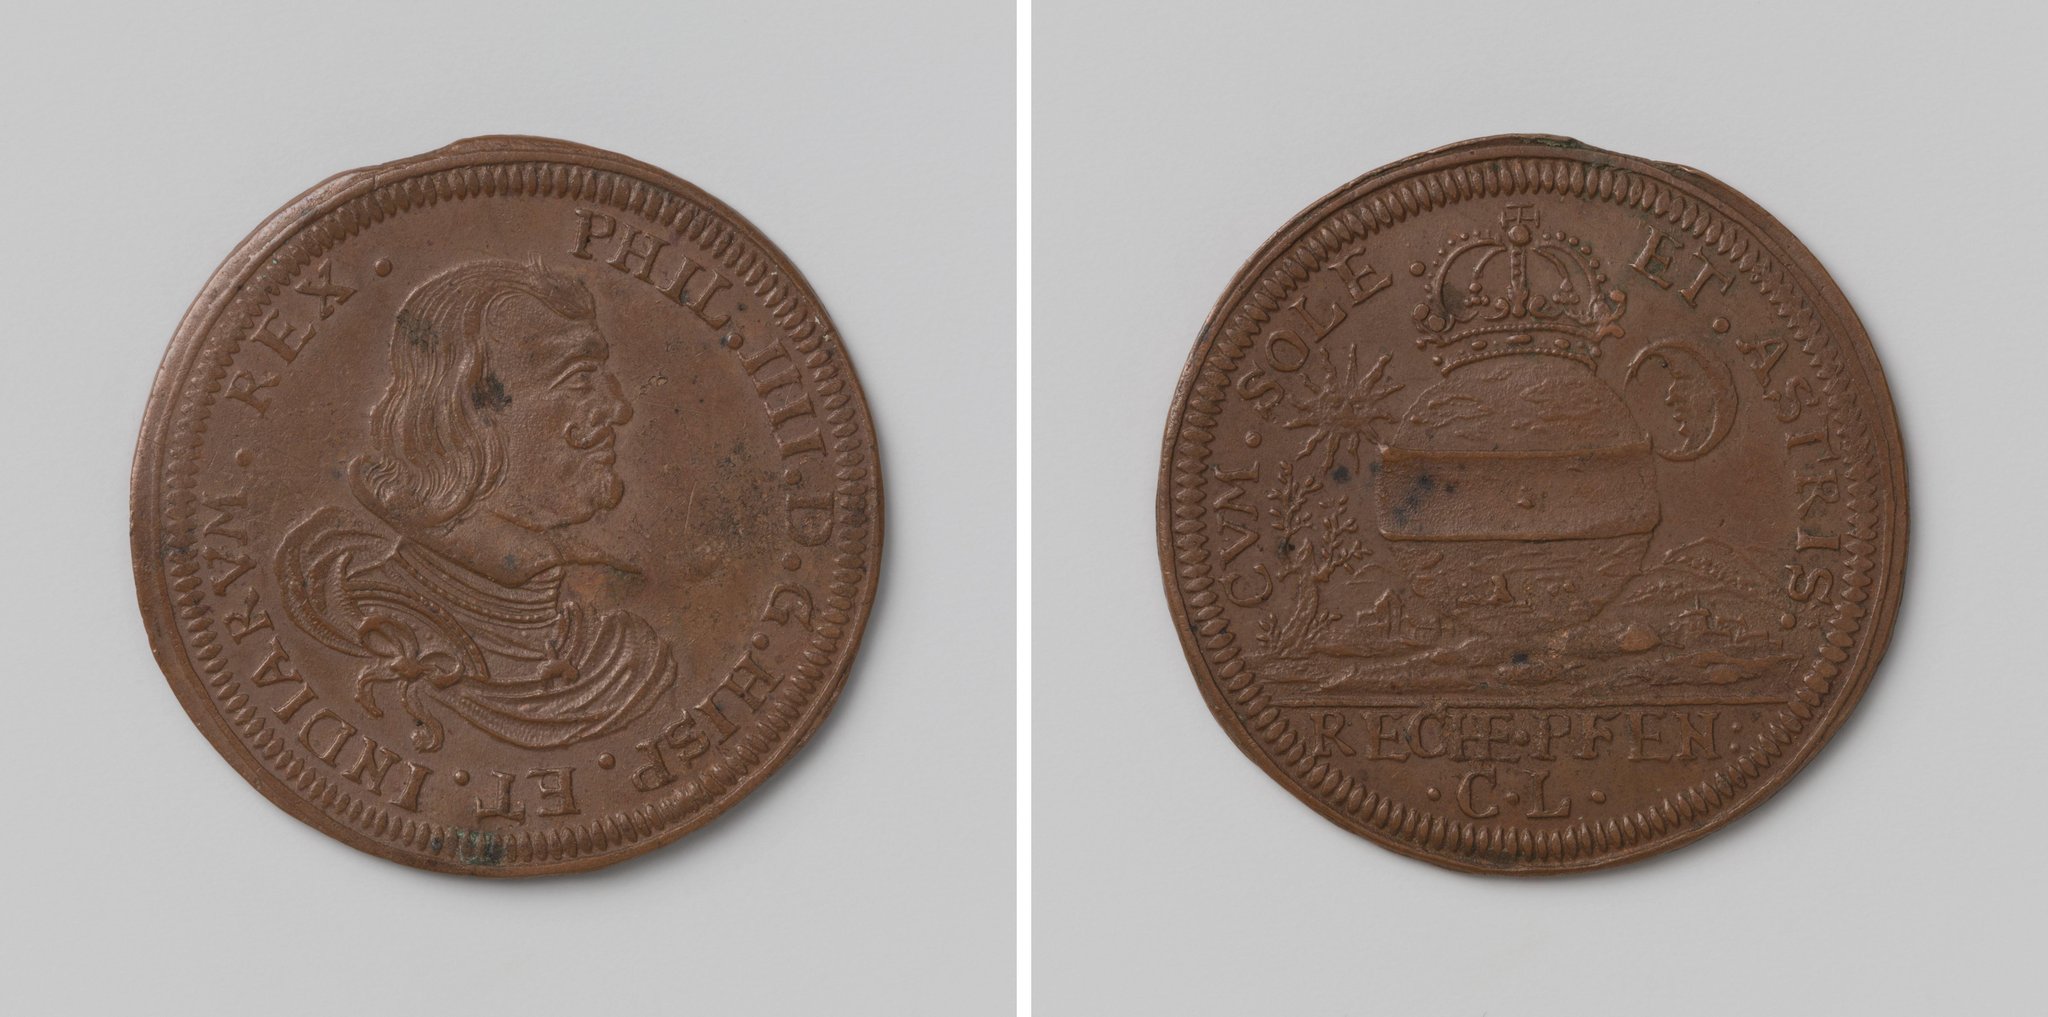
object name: jeton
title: Huwelijk van Filips IV, koning van Spanje en Maria Anna, aartshertogin van Oostenrijk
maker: caspar gottlieb lauffer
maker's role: medailleur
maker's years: 1674-1745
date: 1650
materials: copper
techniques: striking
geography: nuremberg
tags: filips iv (koning van spanje), vienna, maria anna van oostenrijk (koningin van spanje)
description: Koperen penning. Voorzijde: borststuk man binnen omschrift. Keerzijde: gekroonde wereldbol, geflankeerd door zon en maan binnen omschrift; afsnede: opschrift en signatuur